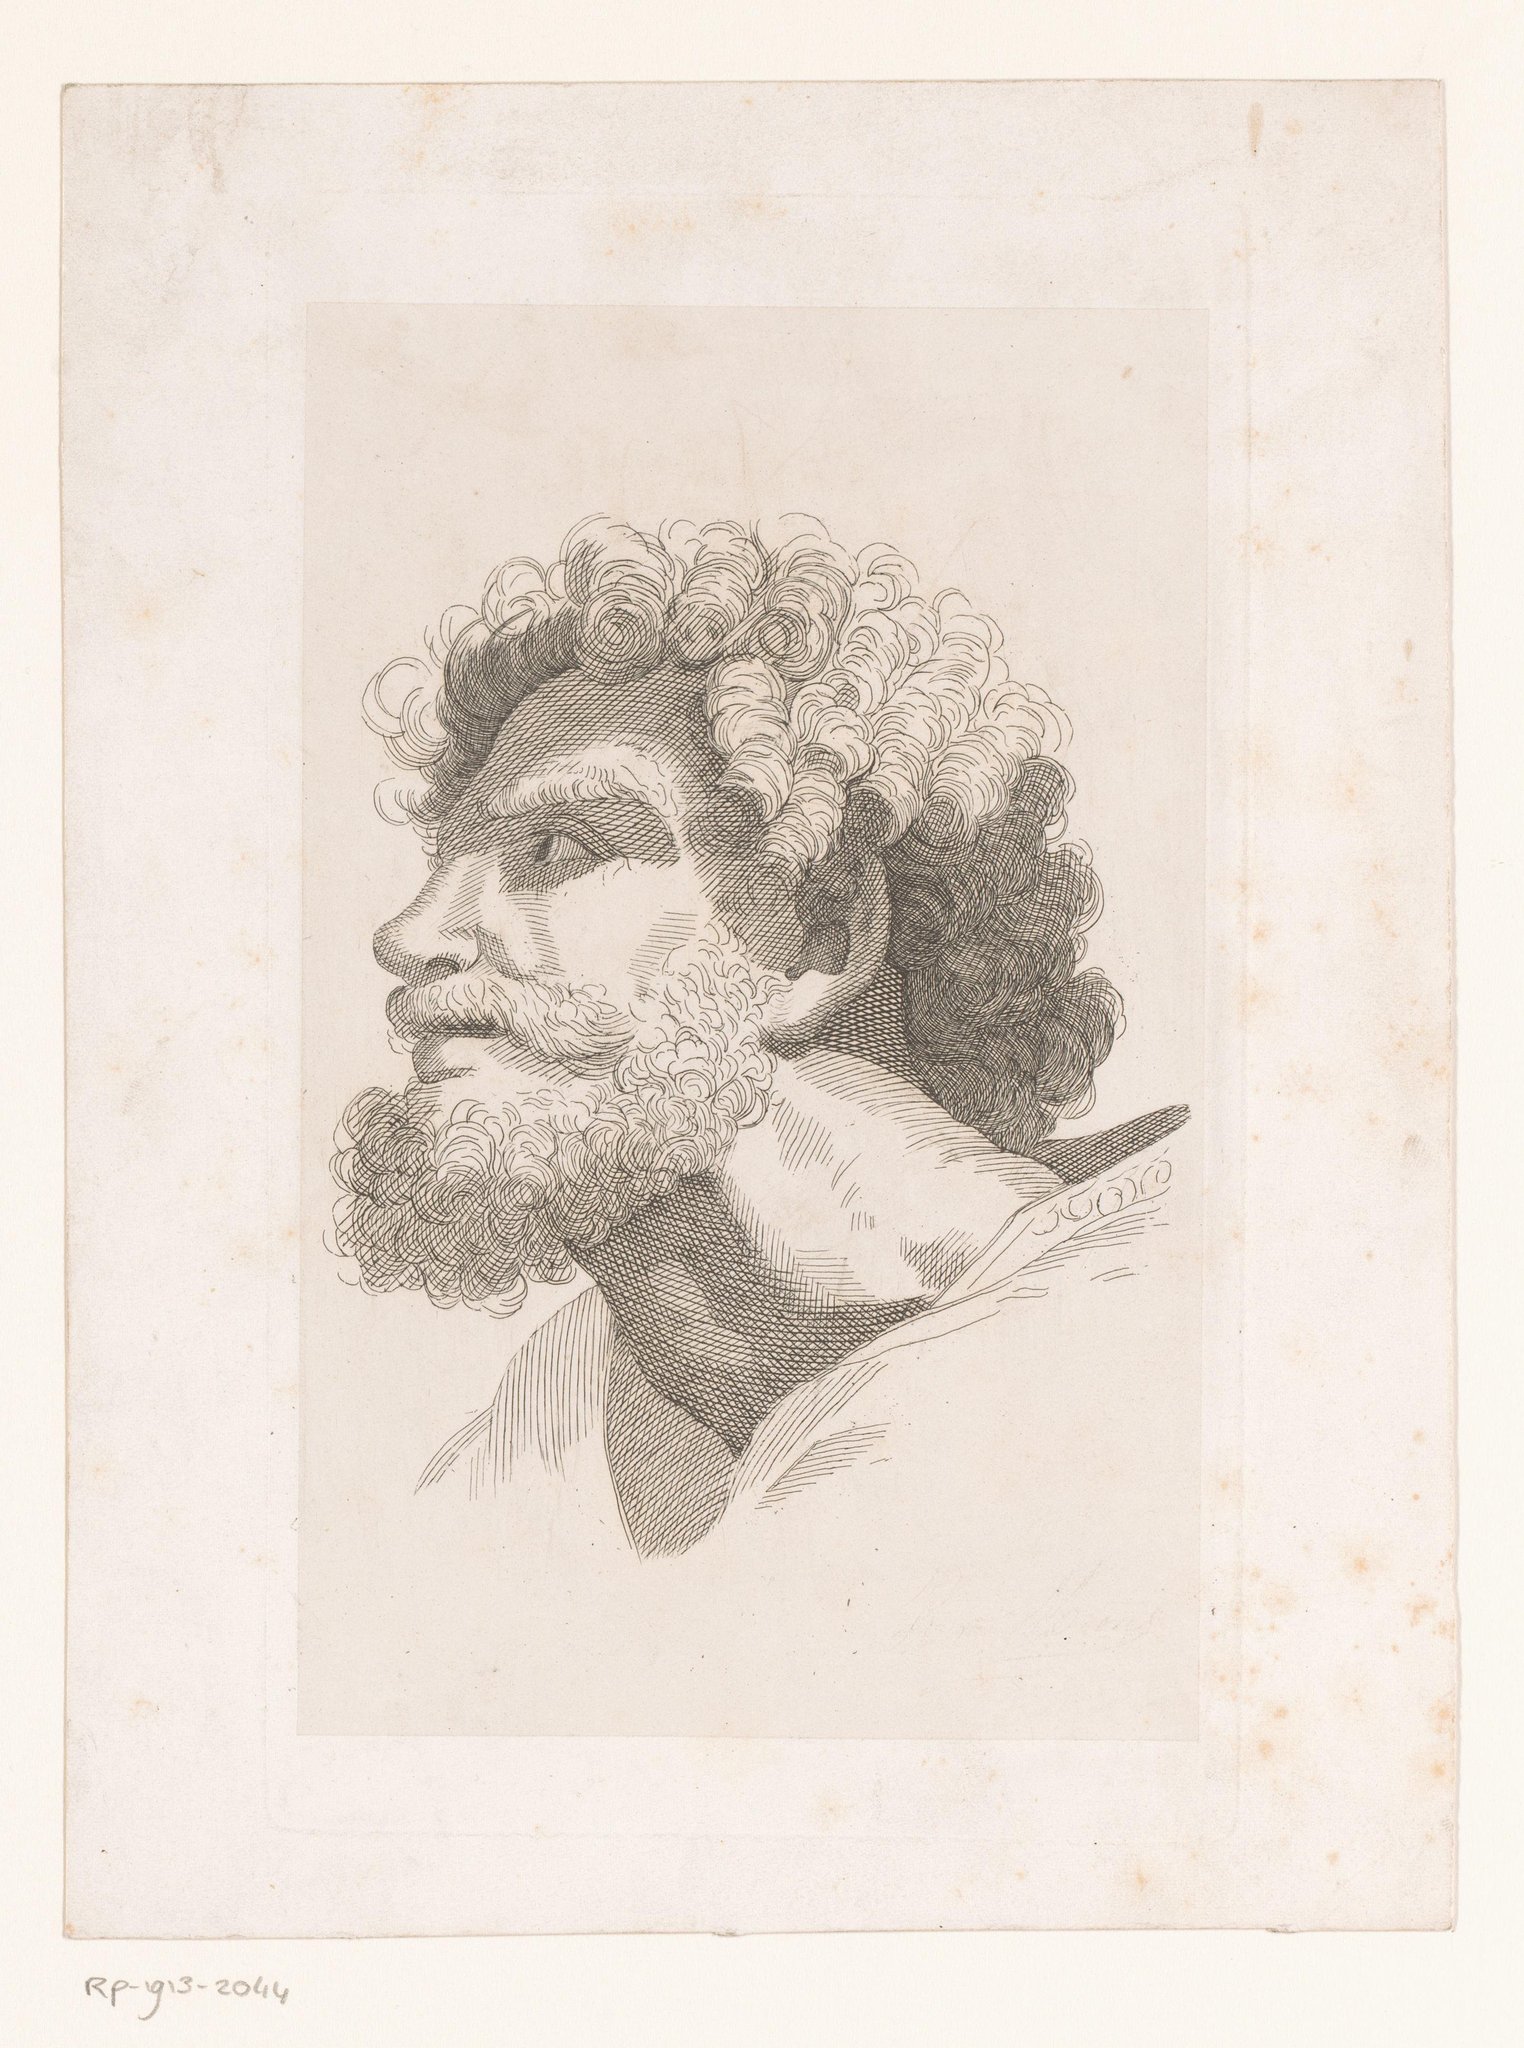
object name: print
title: Hoofd van een man met baard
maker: henry moons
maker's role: print maker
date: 1850-1899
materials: paper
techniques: etching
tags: adult man, beard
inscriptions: collector's mark: Lugt 2228